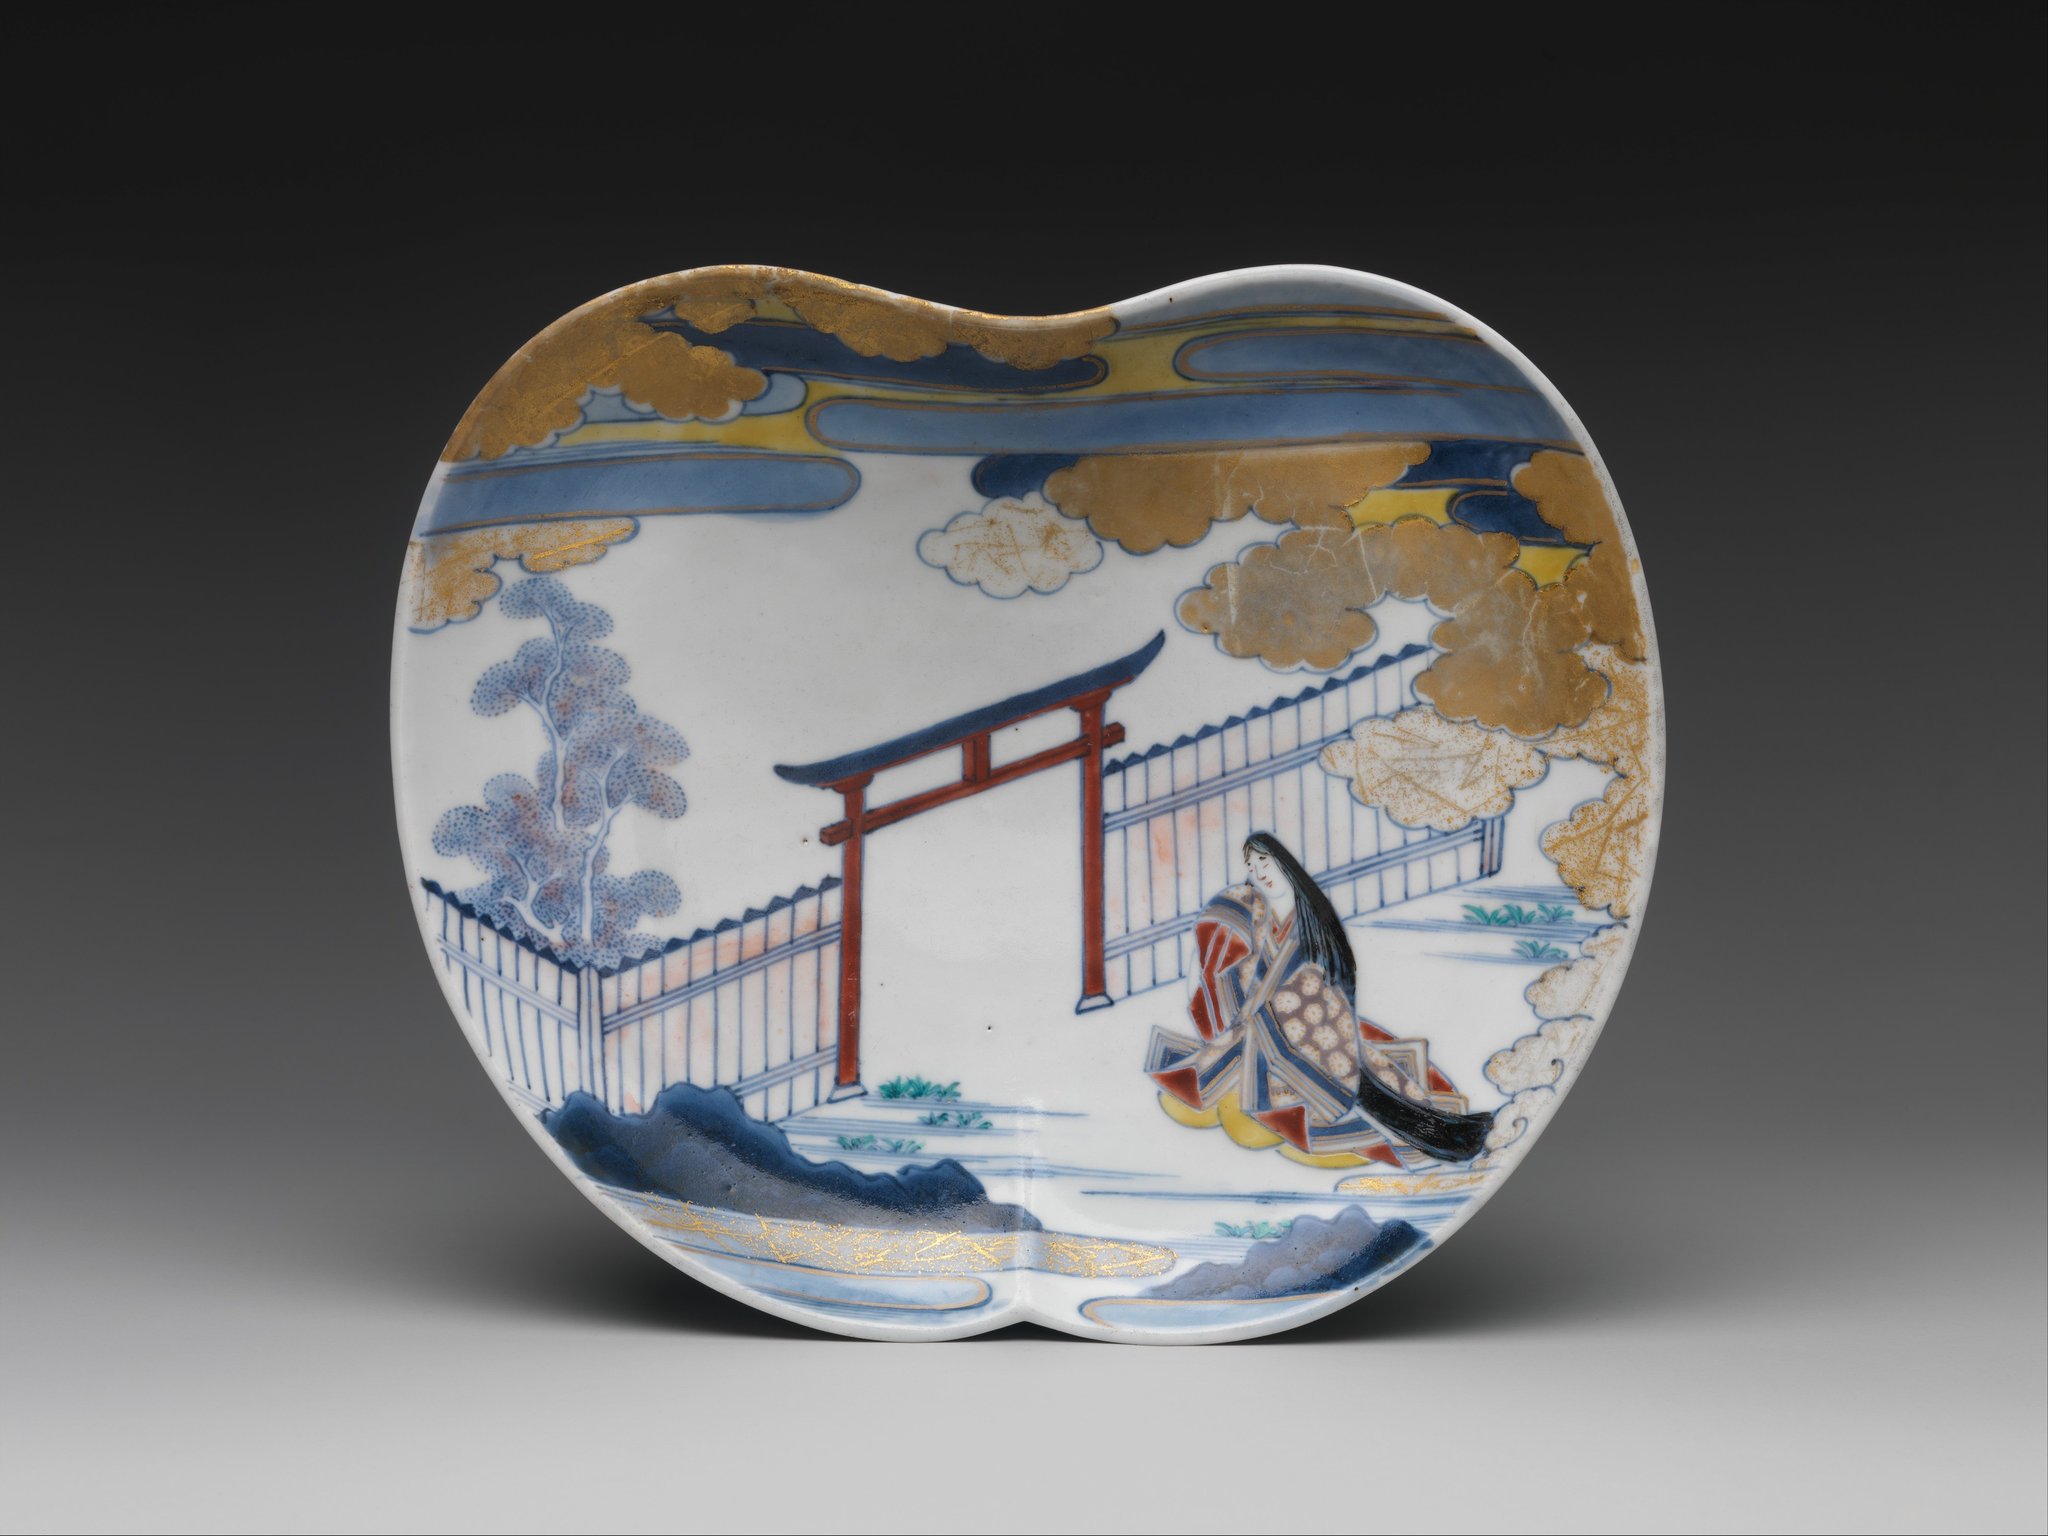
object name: dish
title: Dish with Design of Court Lady by the Gate of a Shinto Shrine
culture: japanese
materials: enamel, gold, porcelain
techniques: overglaze, underglaze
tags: gates,trees